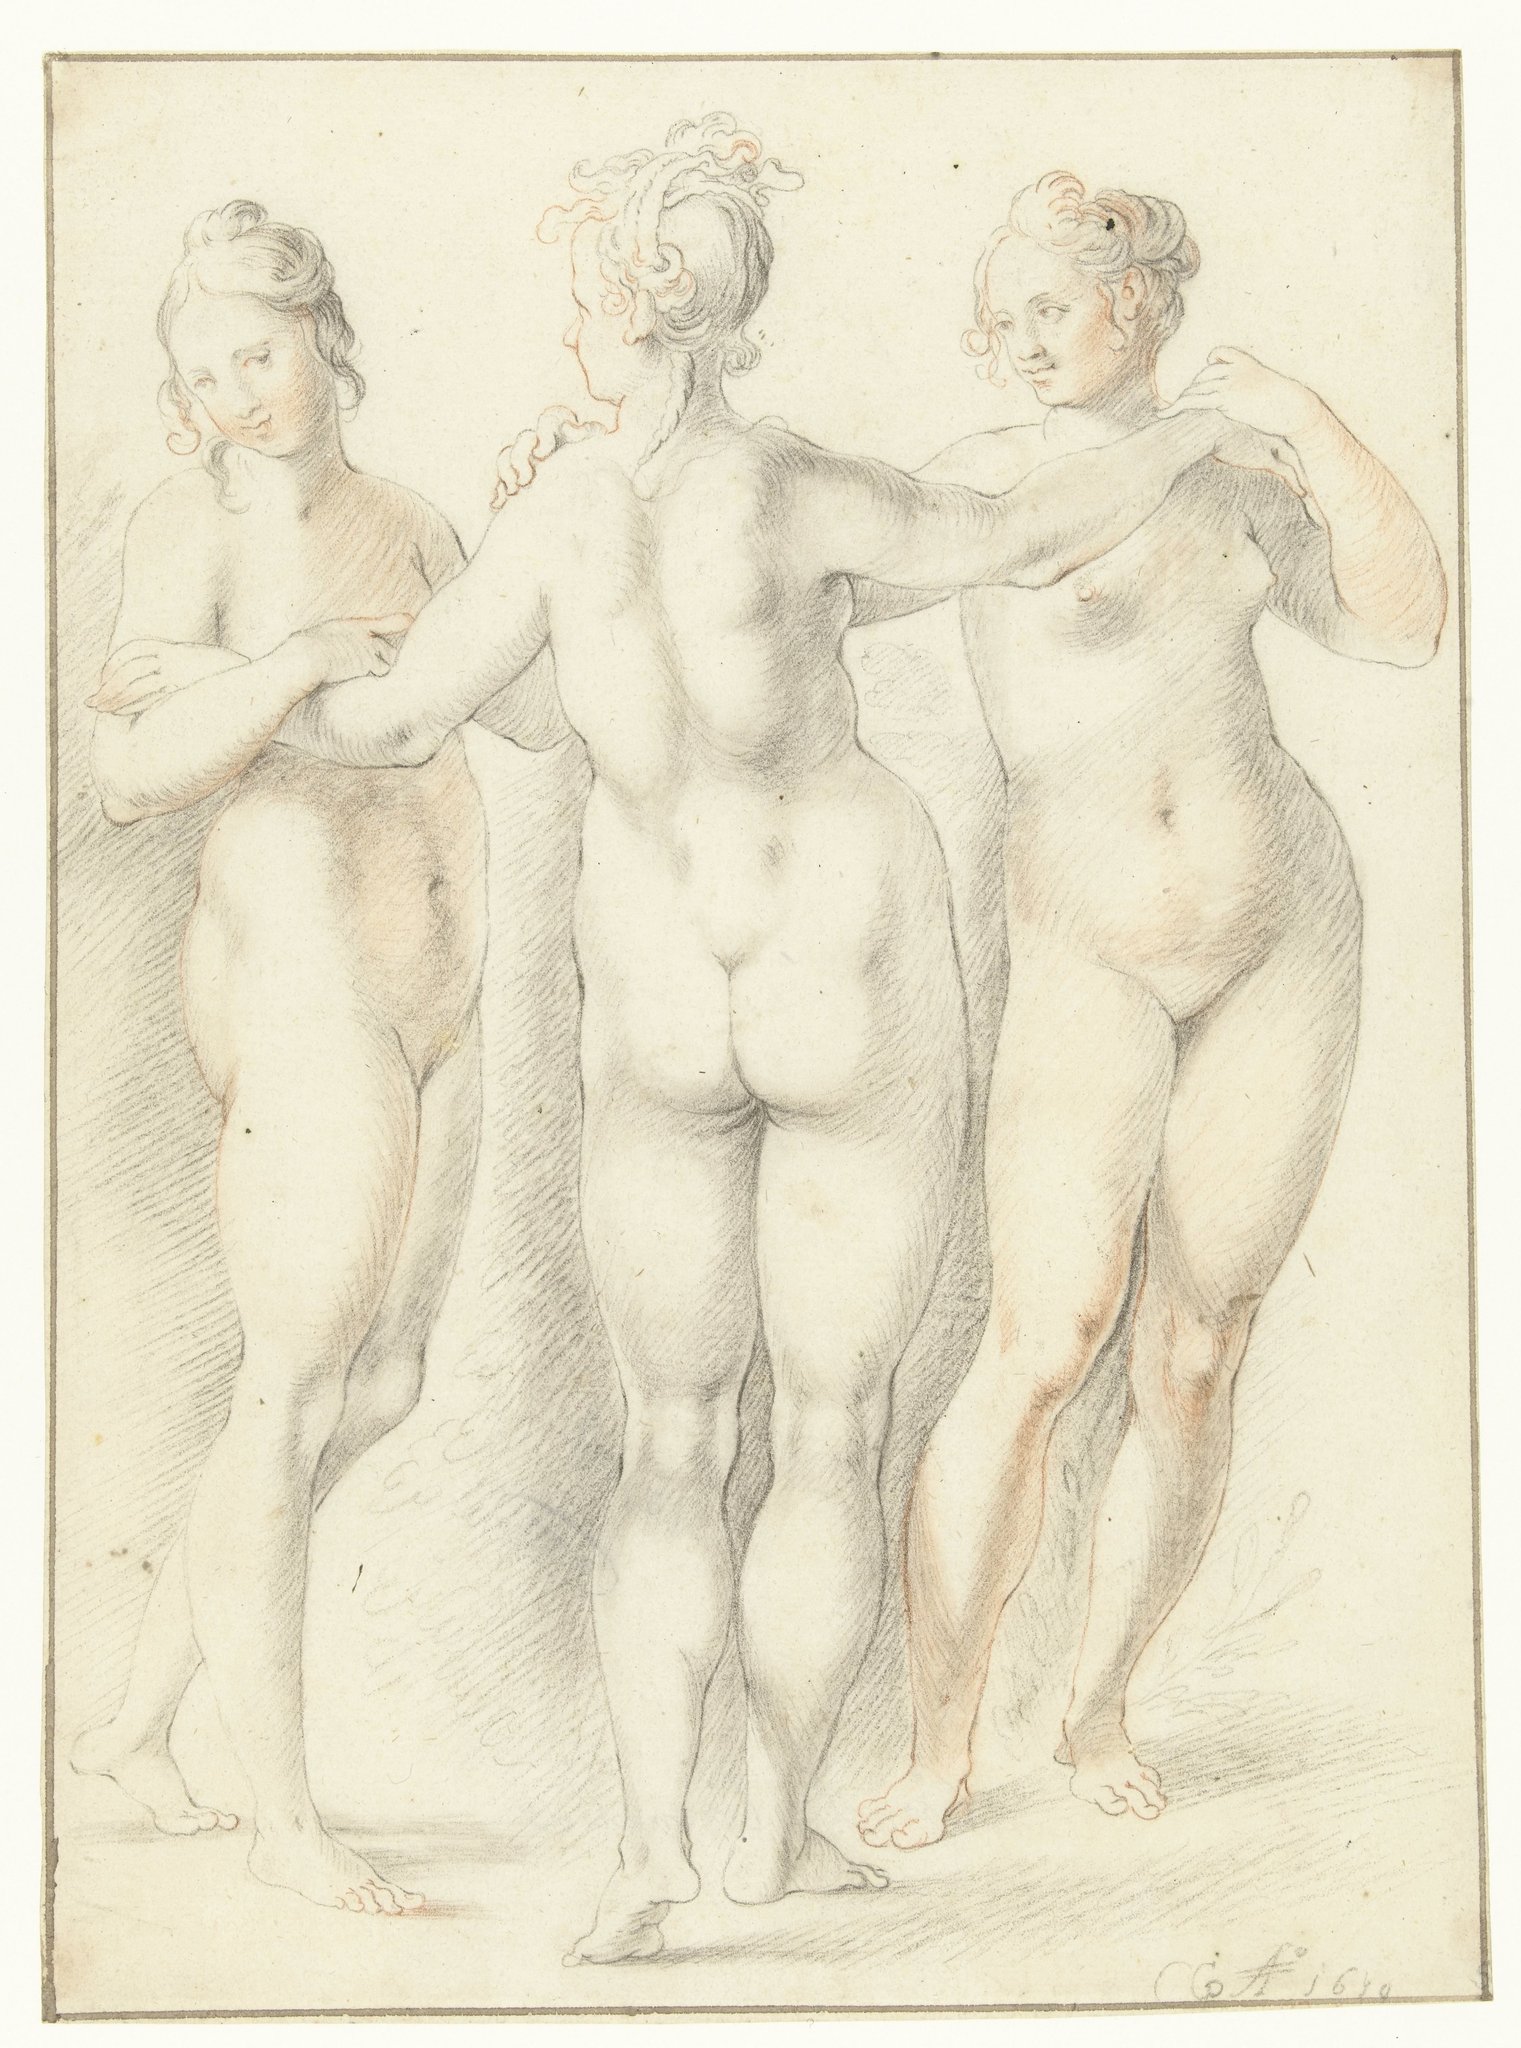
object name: drawing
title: Drie Gratiën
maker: Anonymous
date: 1610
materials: chalk, paper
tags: graces (charites), generally three in number; 'gratie' (ripa)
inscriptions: date